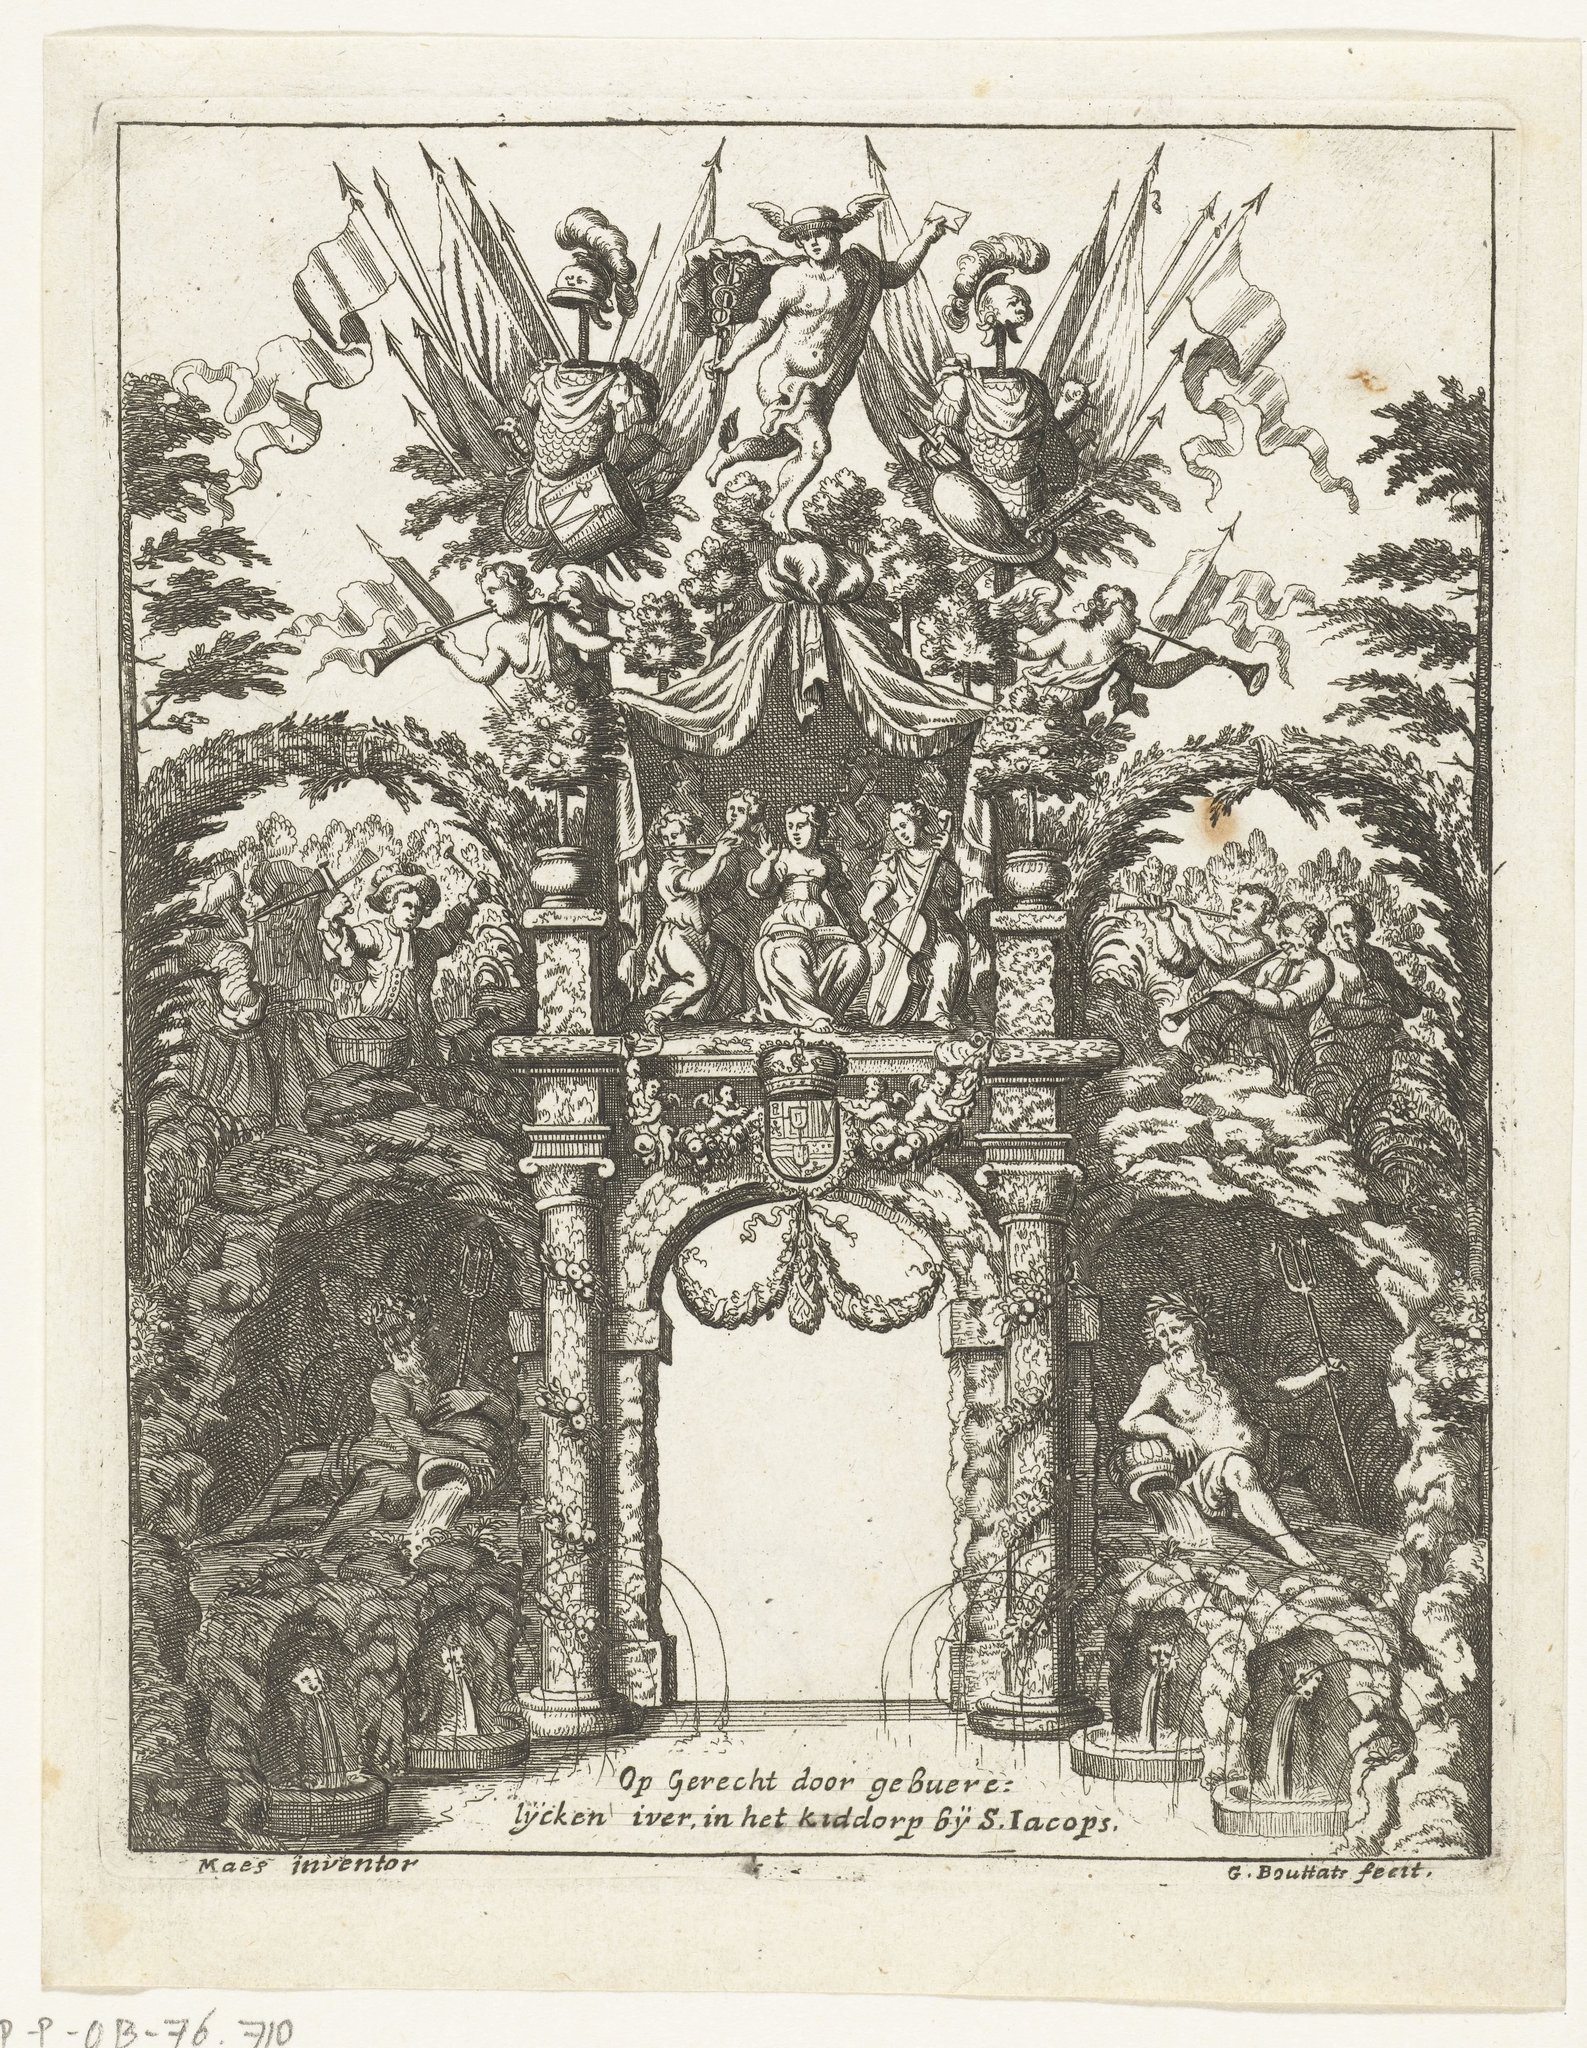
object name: print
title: Triomfpoort opgericht in de Kipdorp bij de Sint-Jacobskerk, 1685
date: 1685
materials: paper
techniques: etching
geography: southern netherlands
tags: triumphal arch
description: Gebruikt als illustratie in: Hondert-jaerigh jubile-vreught bewesen in dese stadt Antwerpen ter oorsaecke vande herstellinge des geloofs in't jaer 1585. door de glorieuse waepenen van sijne catholijcke majesteyt, onder t'beleyt van ... Alexander Farnesius ... / Ghemaeckt ende by-een vergadert door ... Petrus Franciscus de Smidt, Hieronymus Verdussen den jonghere, Antwerpen 1685.